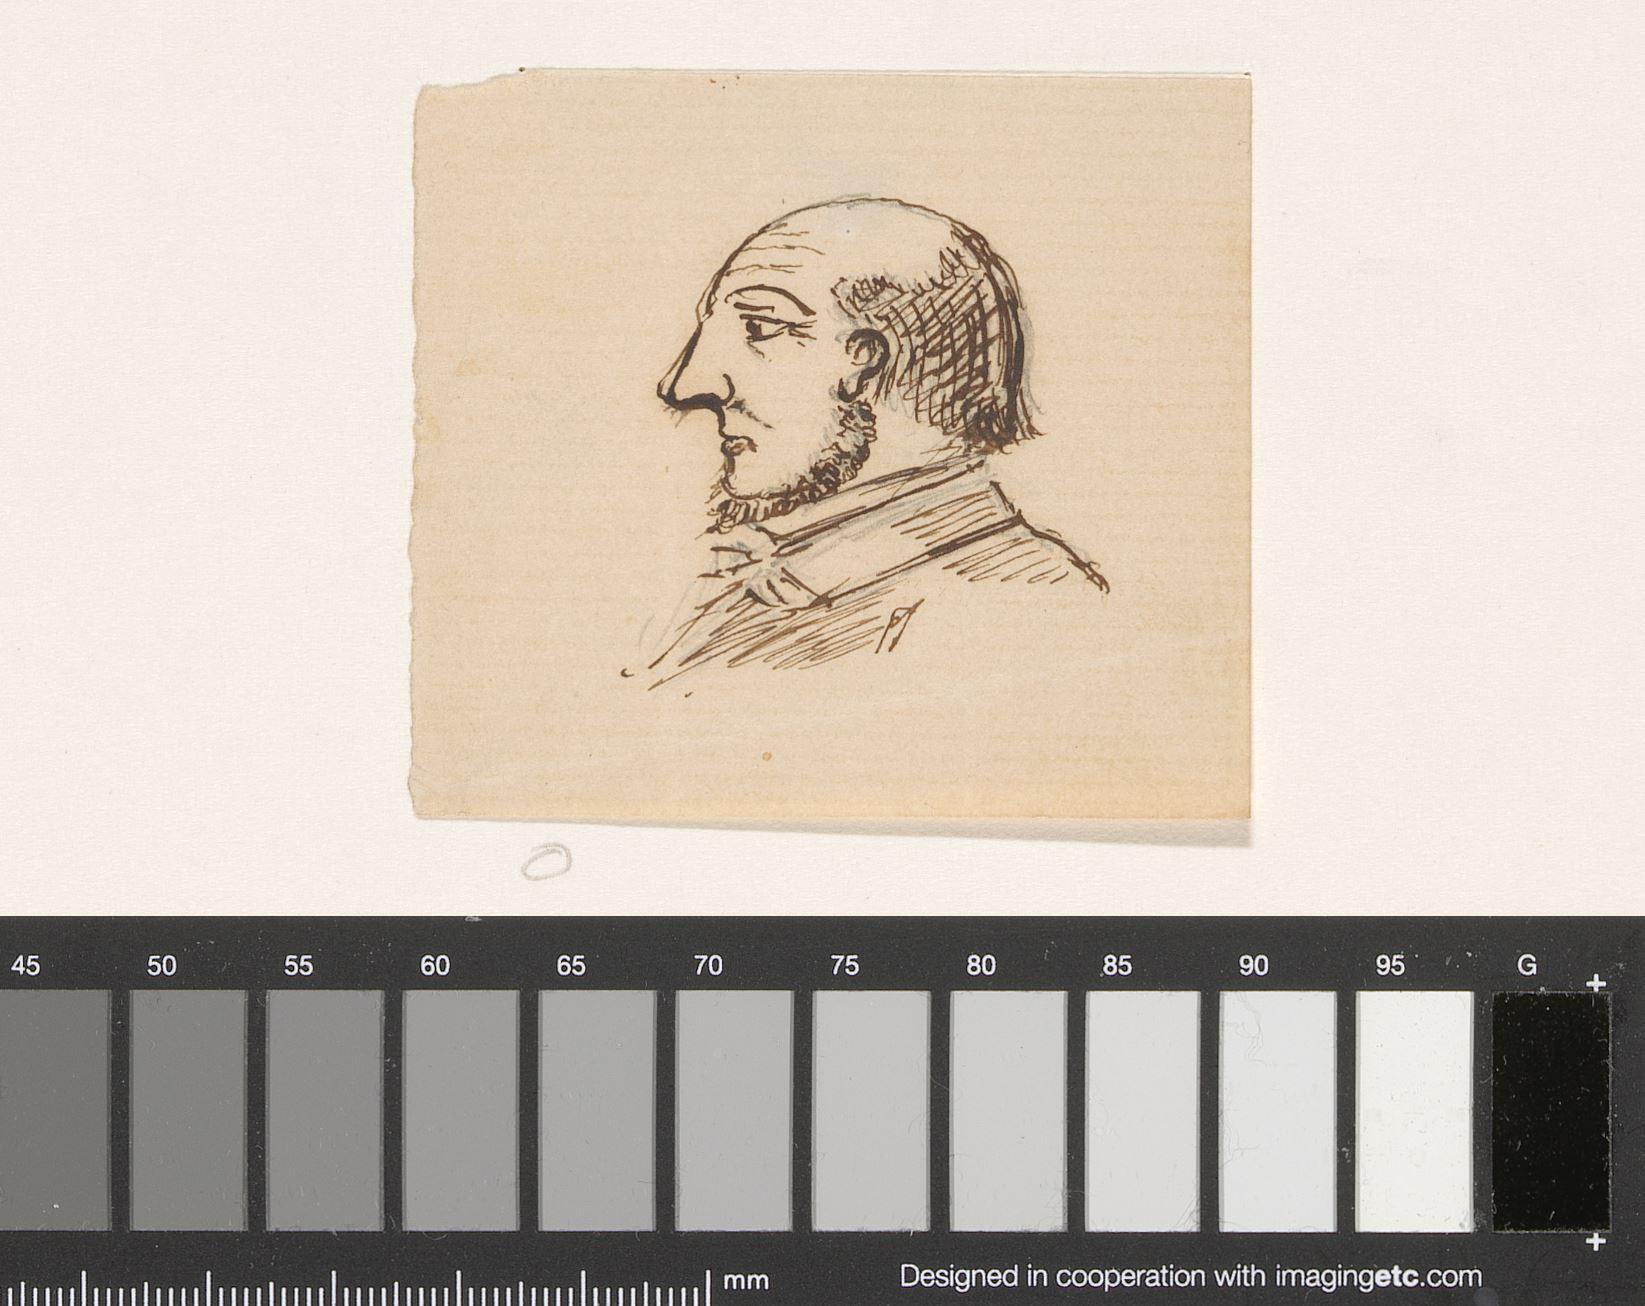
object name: preparatory study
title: Portretschets van onbekende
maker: johan michaël schmidt crans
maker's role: draughtsman, print maker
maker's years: 1830-1907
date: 1875-1895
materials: ink, paper, pencil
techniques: pen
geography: netherlands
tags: political caricatures and satires, historical persons not known by name, netherlands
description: Schets van een onbekende man, waarschijnlijk een kamerlid. Voorstudie voor politieke spotprent.